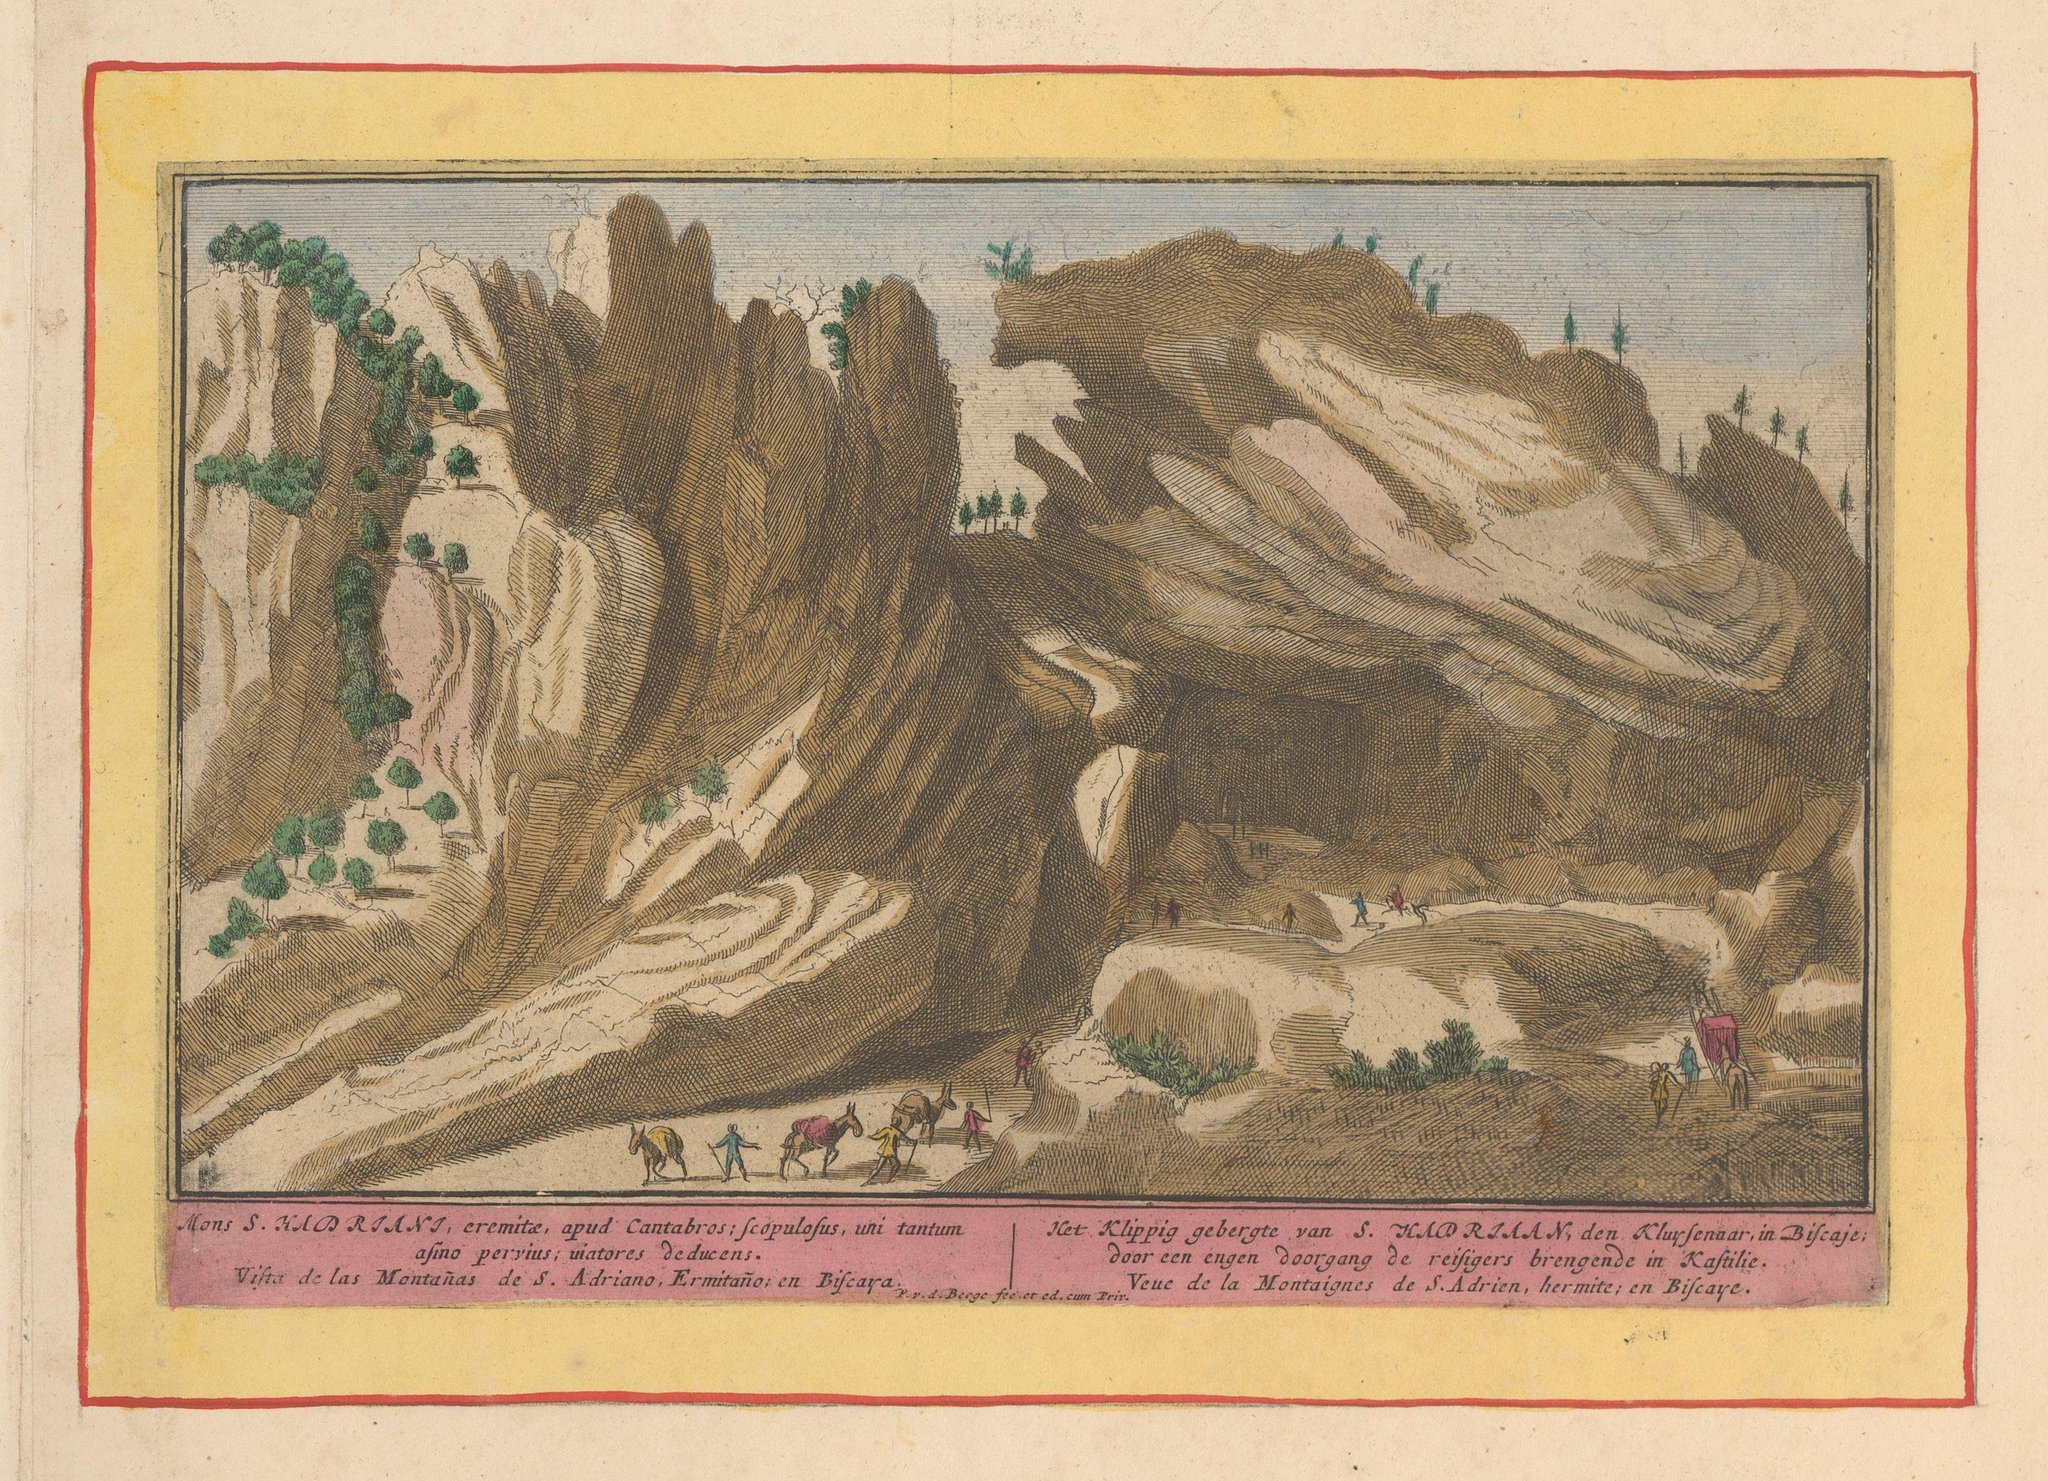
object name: album leaf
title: Het Klippig gebergte van S. Hadriaan, den Kluysebaar, in Biscaje; door een engen doorgang de reisigers brengende in Kastilie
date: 1694-1737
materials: paper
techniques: etching, hand coloring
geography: amsterdam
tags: mountains, vizcaya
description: Prent uit: Theatrum Hispaniæ, exhibens regni urbes, villas ac viridaria magis illustria. Het aanmerkelykste en voortreffelykste in Spanjen (...). Amsterdam: Pieter van den Berge, ca. 1694-1737.